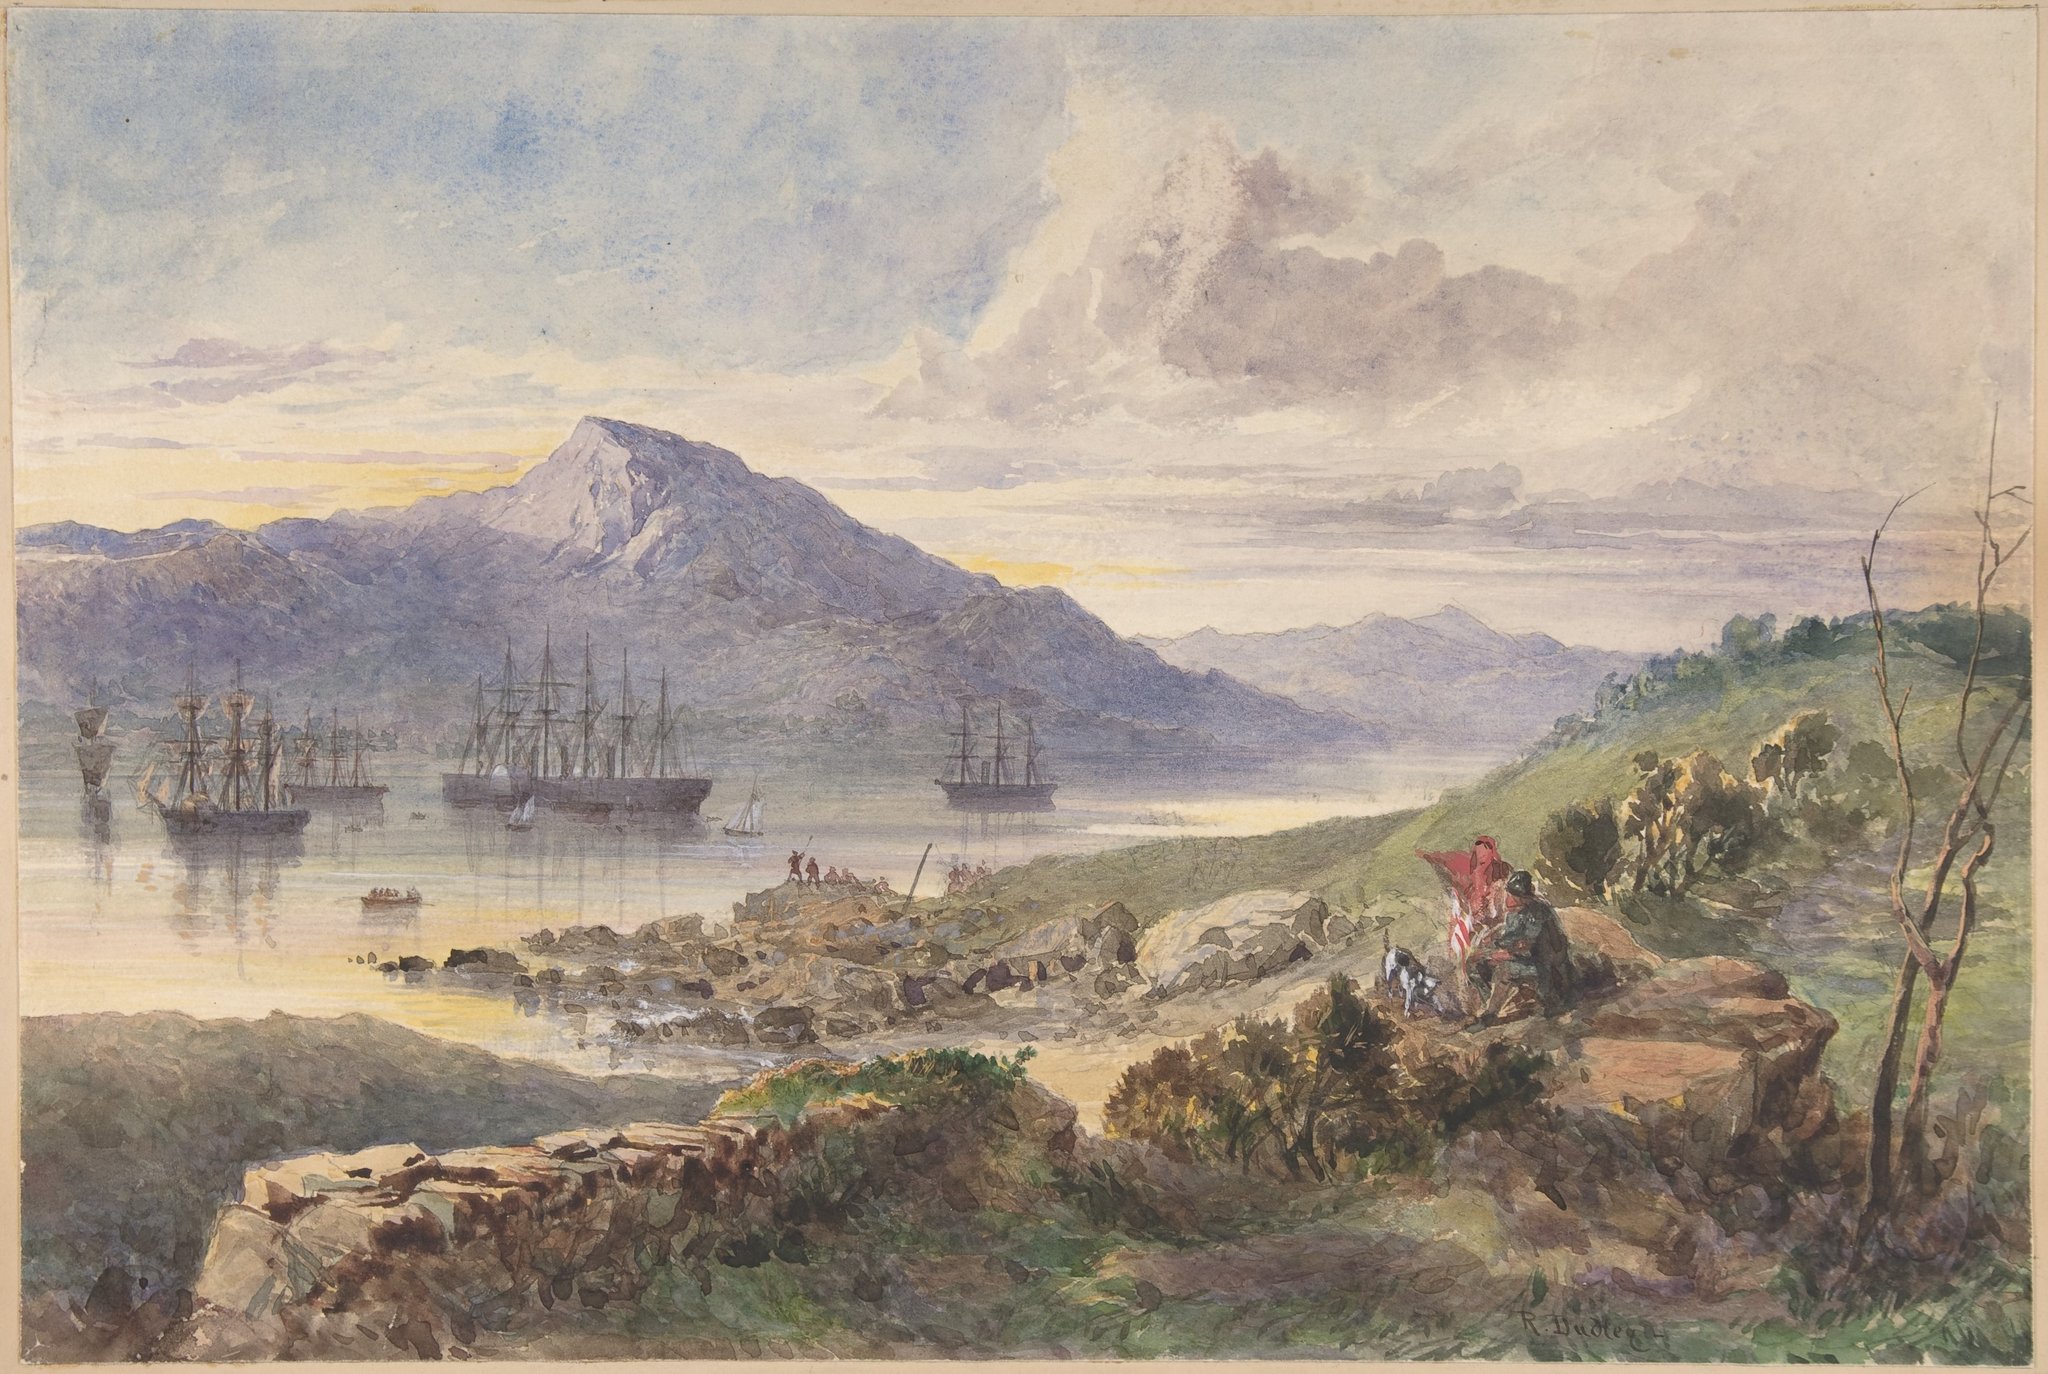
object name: drawing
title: The Heights over Foilhummerum Bay, Valentia, the William Corey Heading Seawards, Laying the Shore-end of the Atlantic Telegraph Cable, July 7th, 1866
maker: robert charles dudley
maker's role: artist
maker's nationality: british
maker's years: 1826-1909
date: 1865-1866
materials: gouache, graphite, watercolor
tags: mountains,landscapes,industry,ships,transatlantic cable